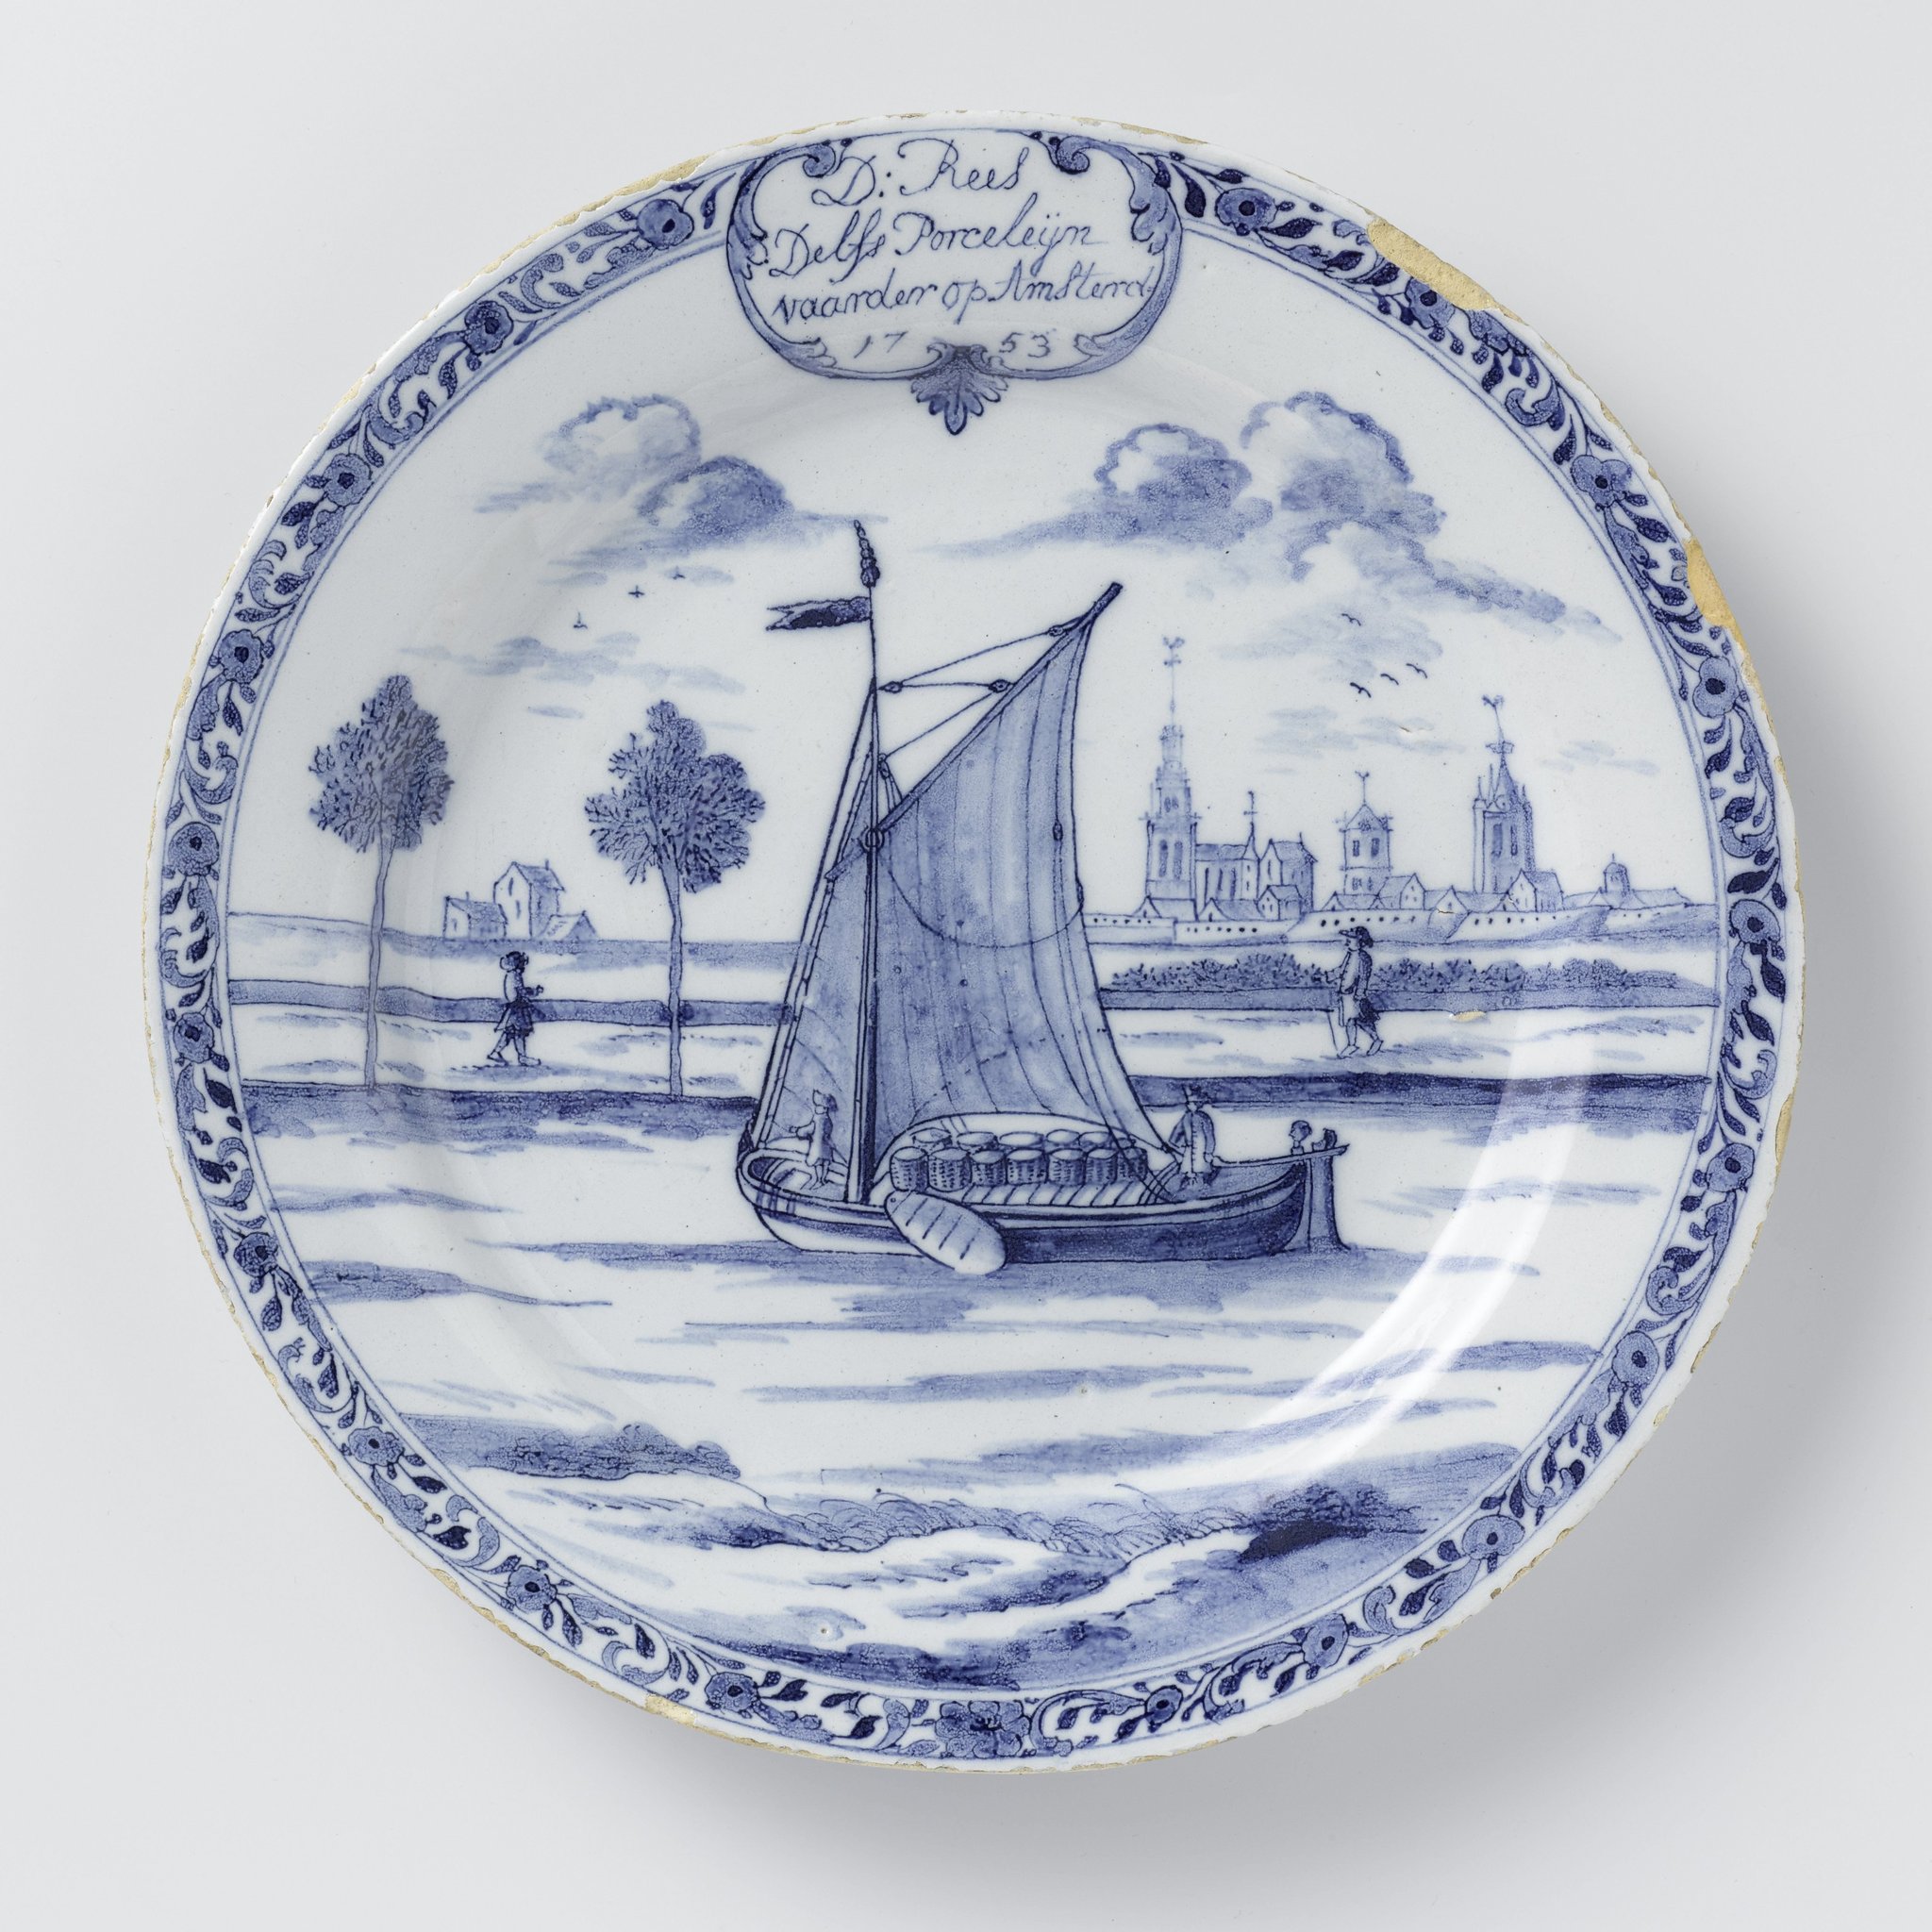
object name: plate dish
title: Bord met een schip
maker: justus brouwer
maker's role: print maker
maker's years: 1646-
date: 1753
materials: faience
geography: delft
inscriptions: inscription: ‘D: Rees/ Delfs Porceleijn/ vaarder op Amsterdam/ 1753’, mark: ‘HB/ figuratief teken bijltje met L’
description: Bord van aardewerk blauw beschilderd op wit tinglazuur, binnen een rand van bloem- en bladwerk een voorstelling van een schip beladen met aardewerk dat door een kanaal vaart. Op de achtergrond de Nieuwe Kerk, de Oude Kerk het stadhuis van Delft. In een cartouche de tekst: D: Rees/ Delfs Porceleijn/ vaarder op Amsterdam/ 1753